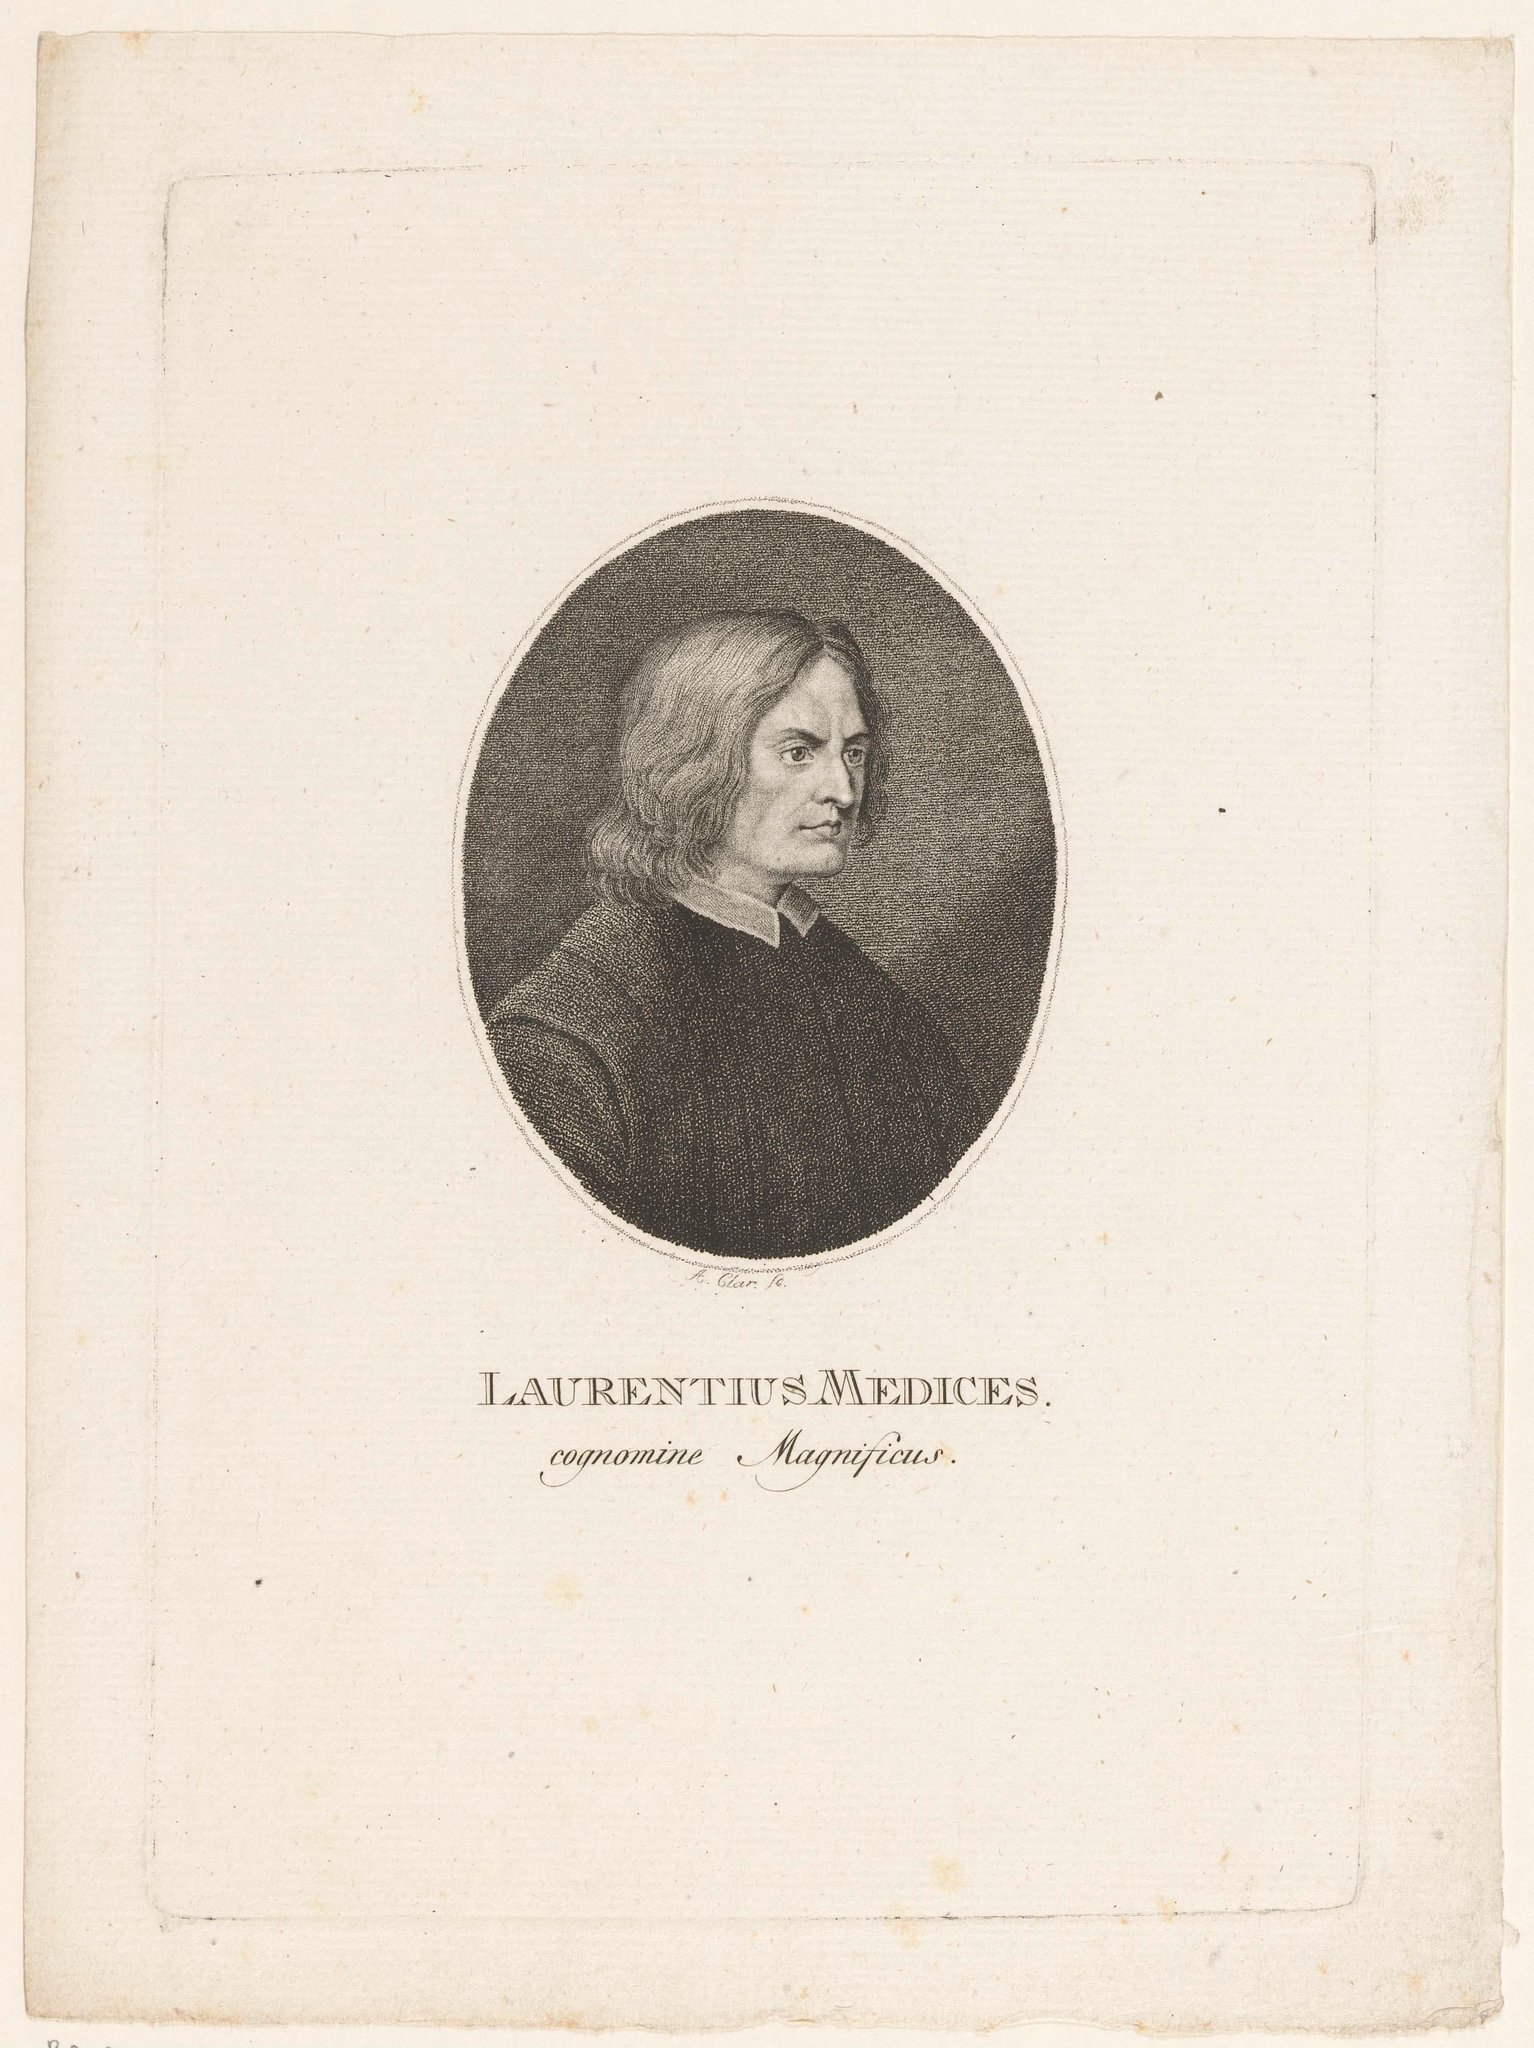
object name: print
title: Portret van Lorenzo de' Medici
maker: johann friedrich august clar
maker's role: print maker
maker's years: 1768-1844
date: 1778-1844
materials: paper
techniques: engraving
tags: politician, historical persons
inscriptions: collector's mark: Lugt 2228